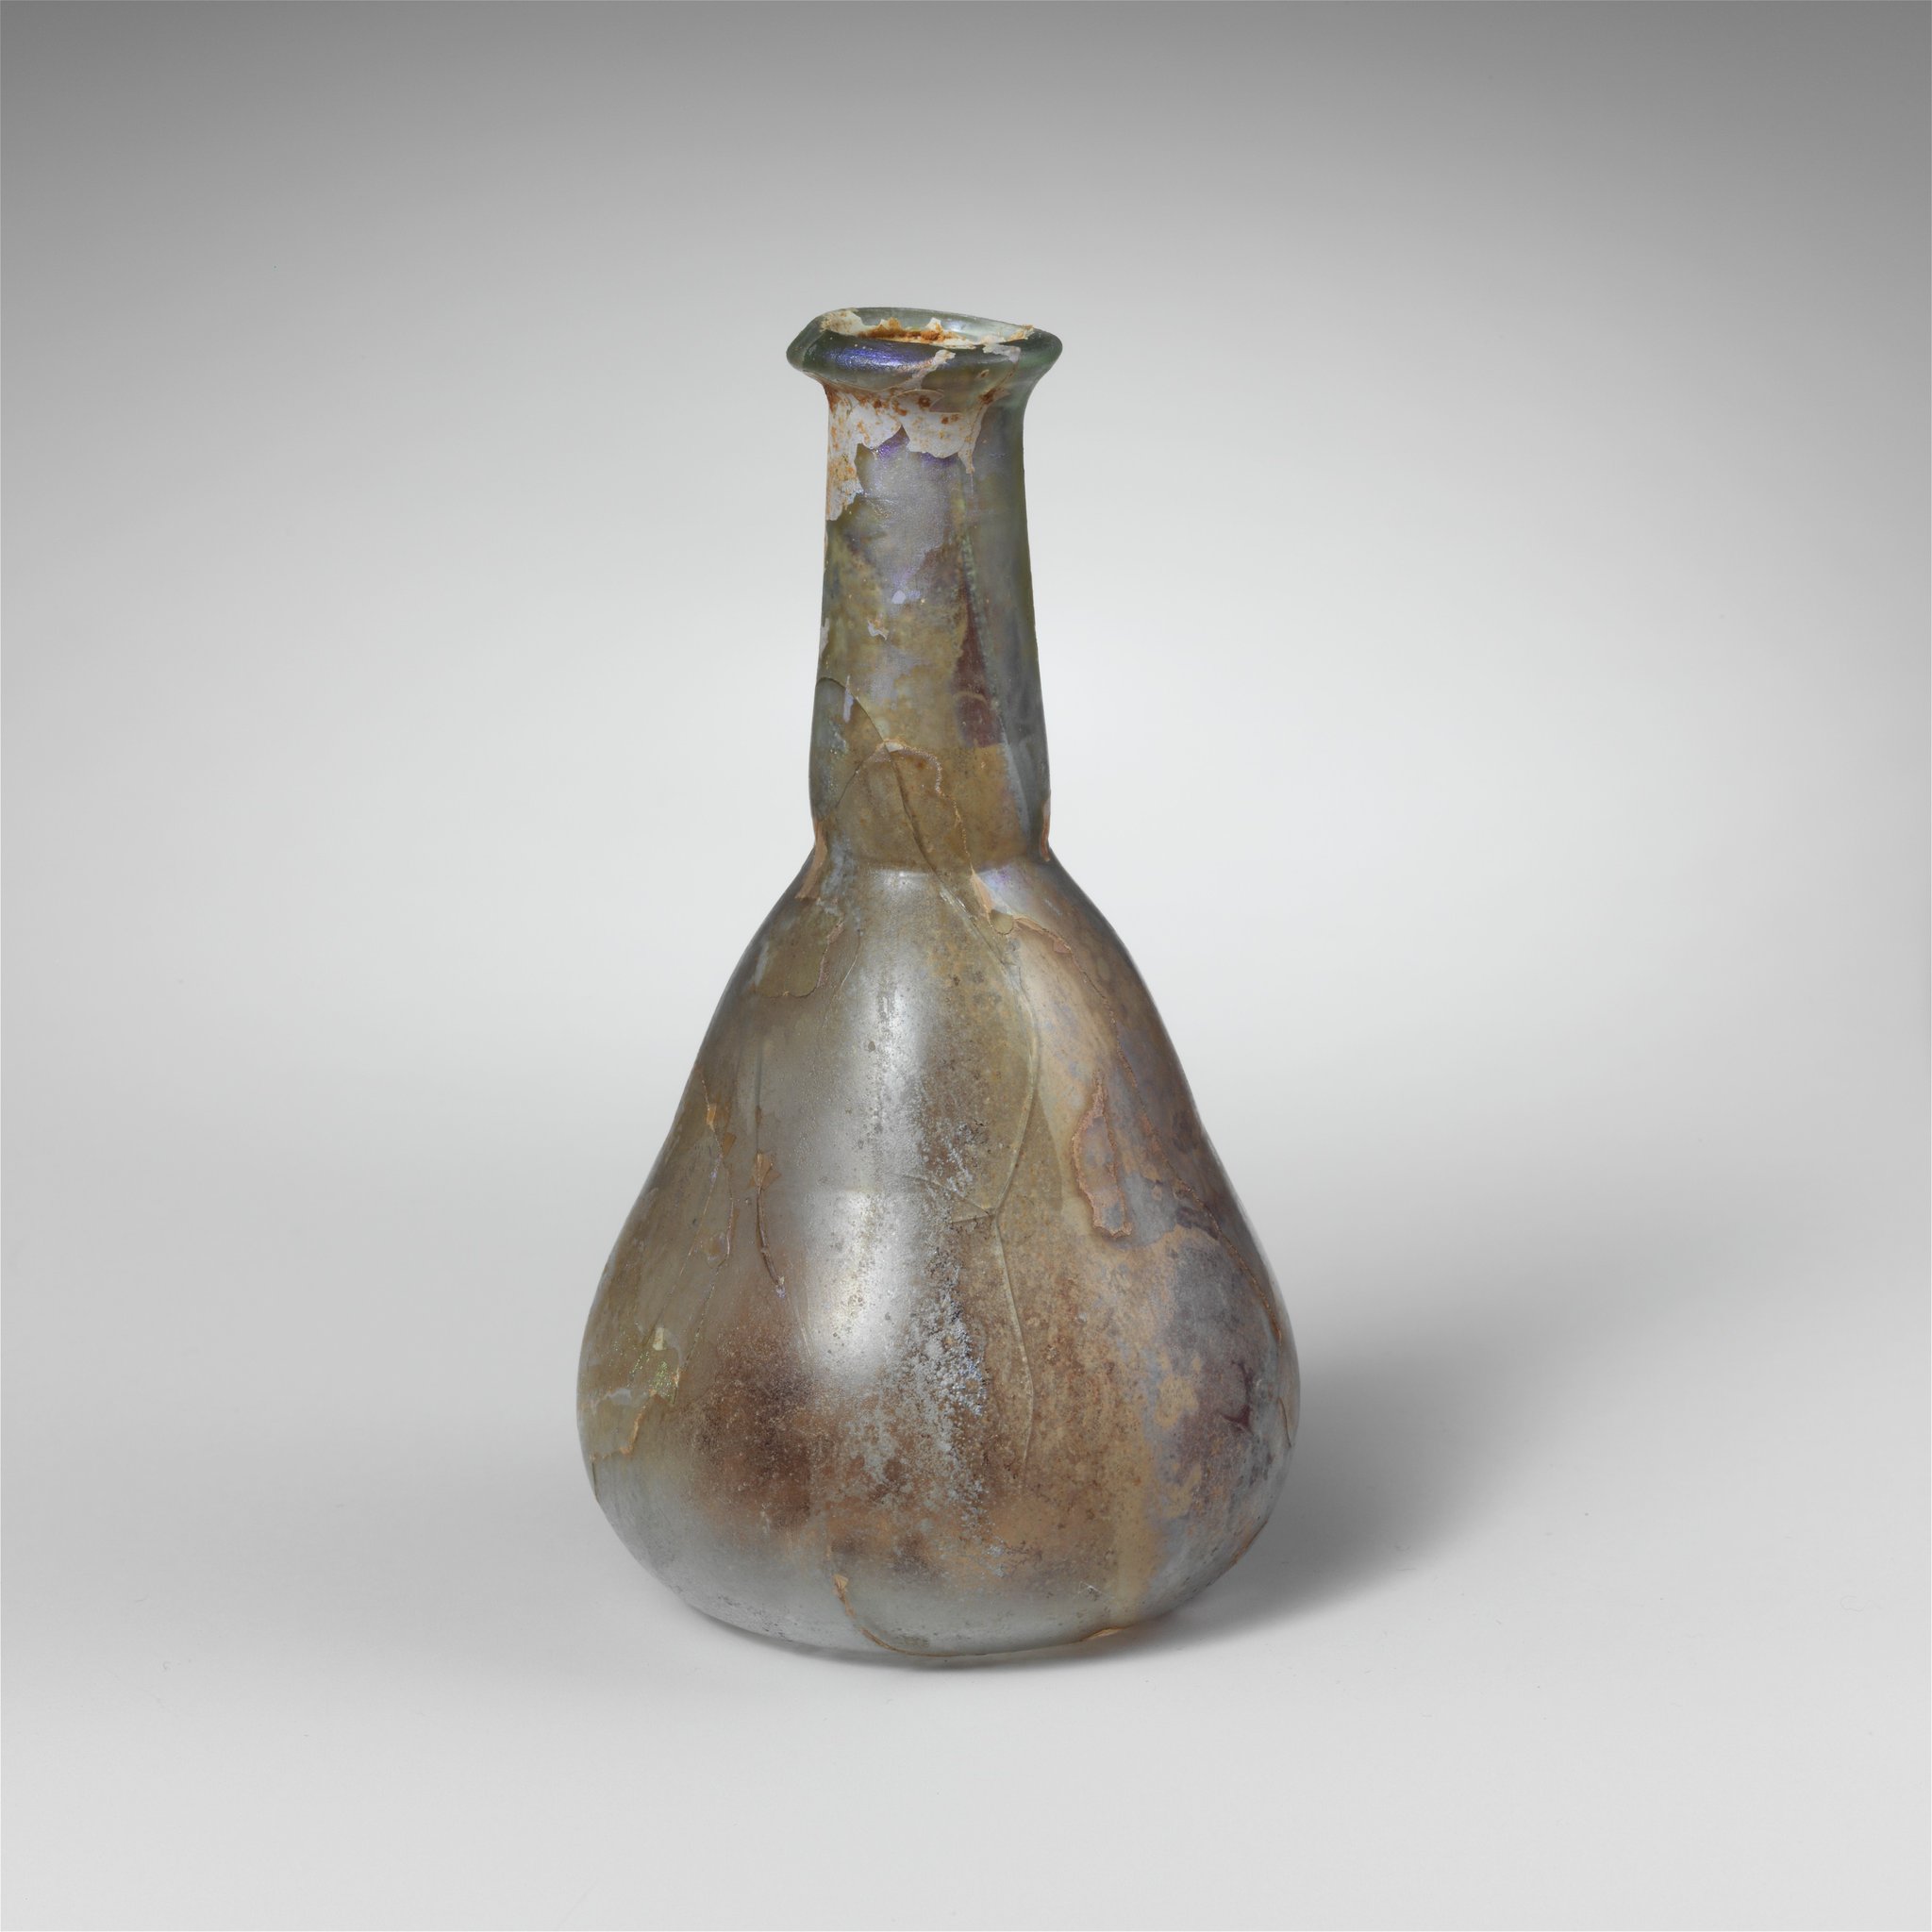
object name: perfume bottle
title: Glass perfume bottle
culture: roman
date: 1-100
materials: glass